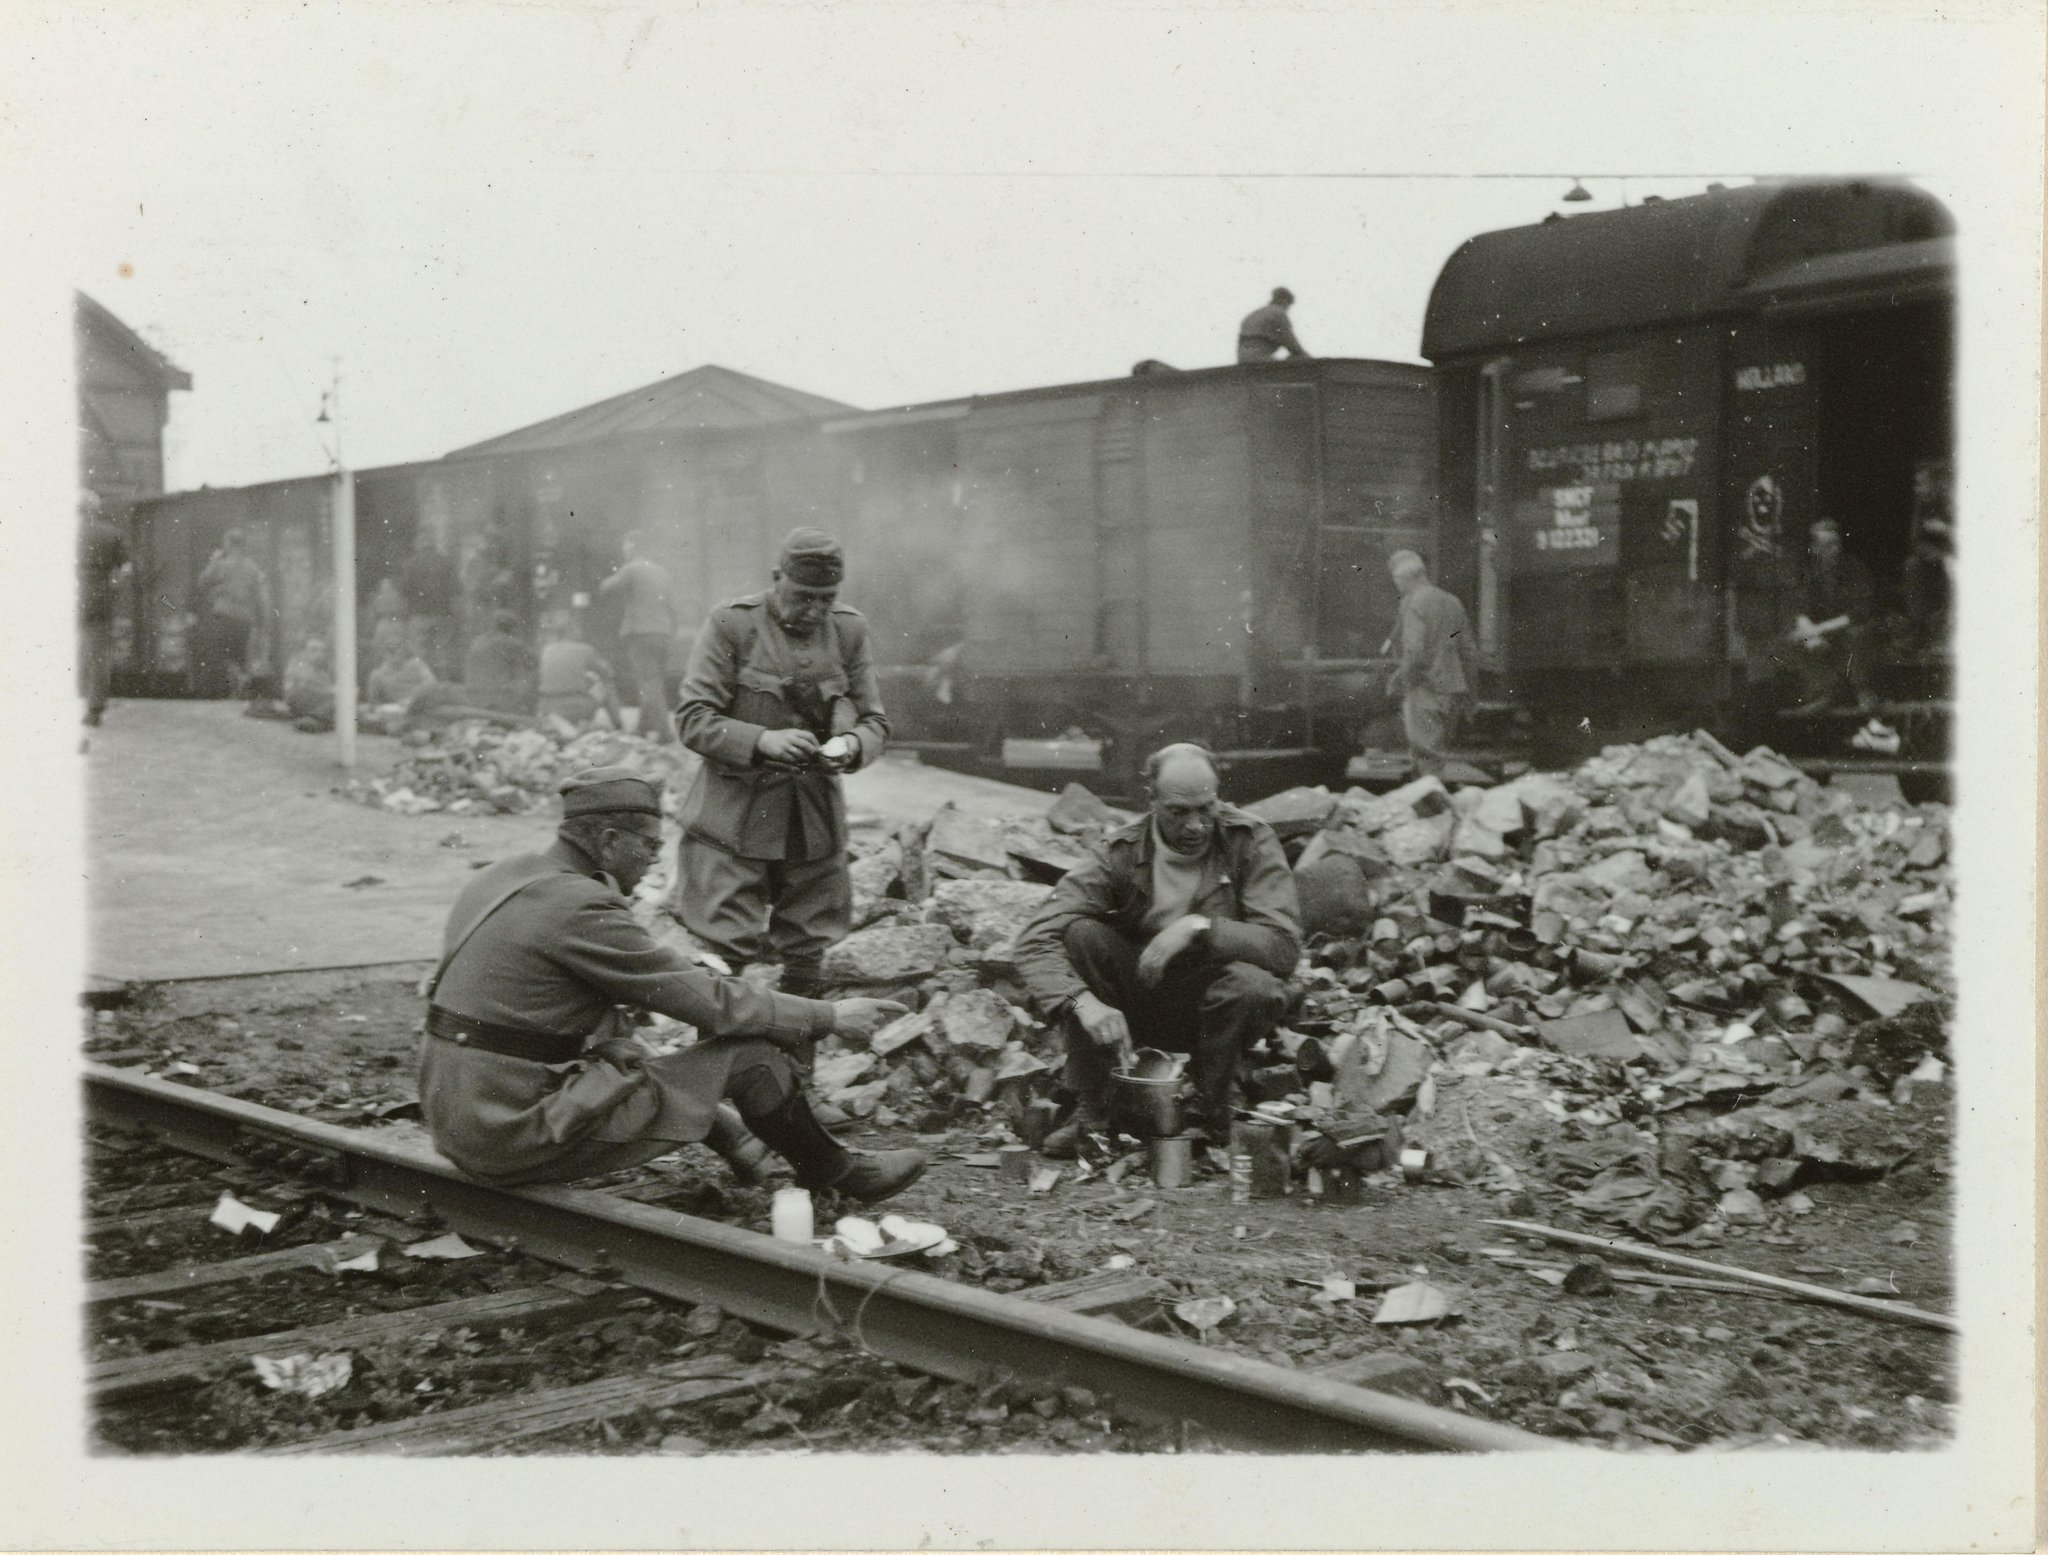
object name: photograph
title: Eten koken onderweg naar huis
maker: dick w.b. van maarseveen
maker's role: fotograaf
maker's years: 1905-1990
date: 1945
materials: photographic support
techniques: gelatin silver print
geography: muhlberg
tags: the hague, dick w.b. van maarseveen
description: Fotograaf Van Maarseveen samen met de twee dominees op de terugweg naar Nederland, tijdens een oponthoud wordt naast de trein wat te eten gemaakt. Onderdeel van een groep foto's gemaakt door Dick van Maarseveen in het Duitse krijgsgevangenenkamp Stalag IV B in Mühlberg in de periode 1943-1945.